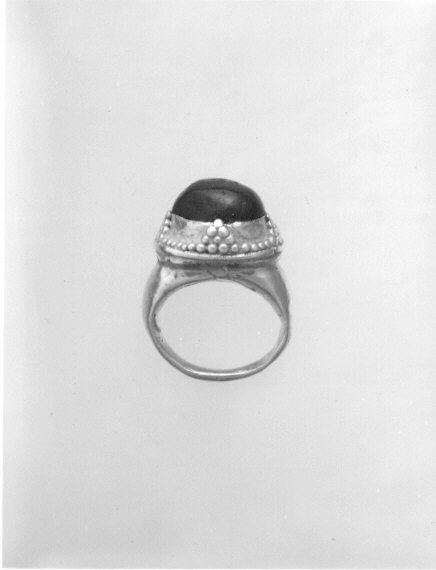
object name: ring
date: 1101-1200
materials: gold, stone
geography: iran